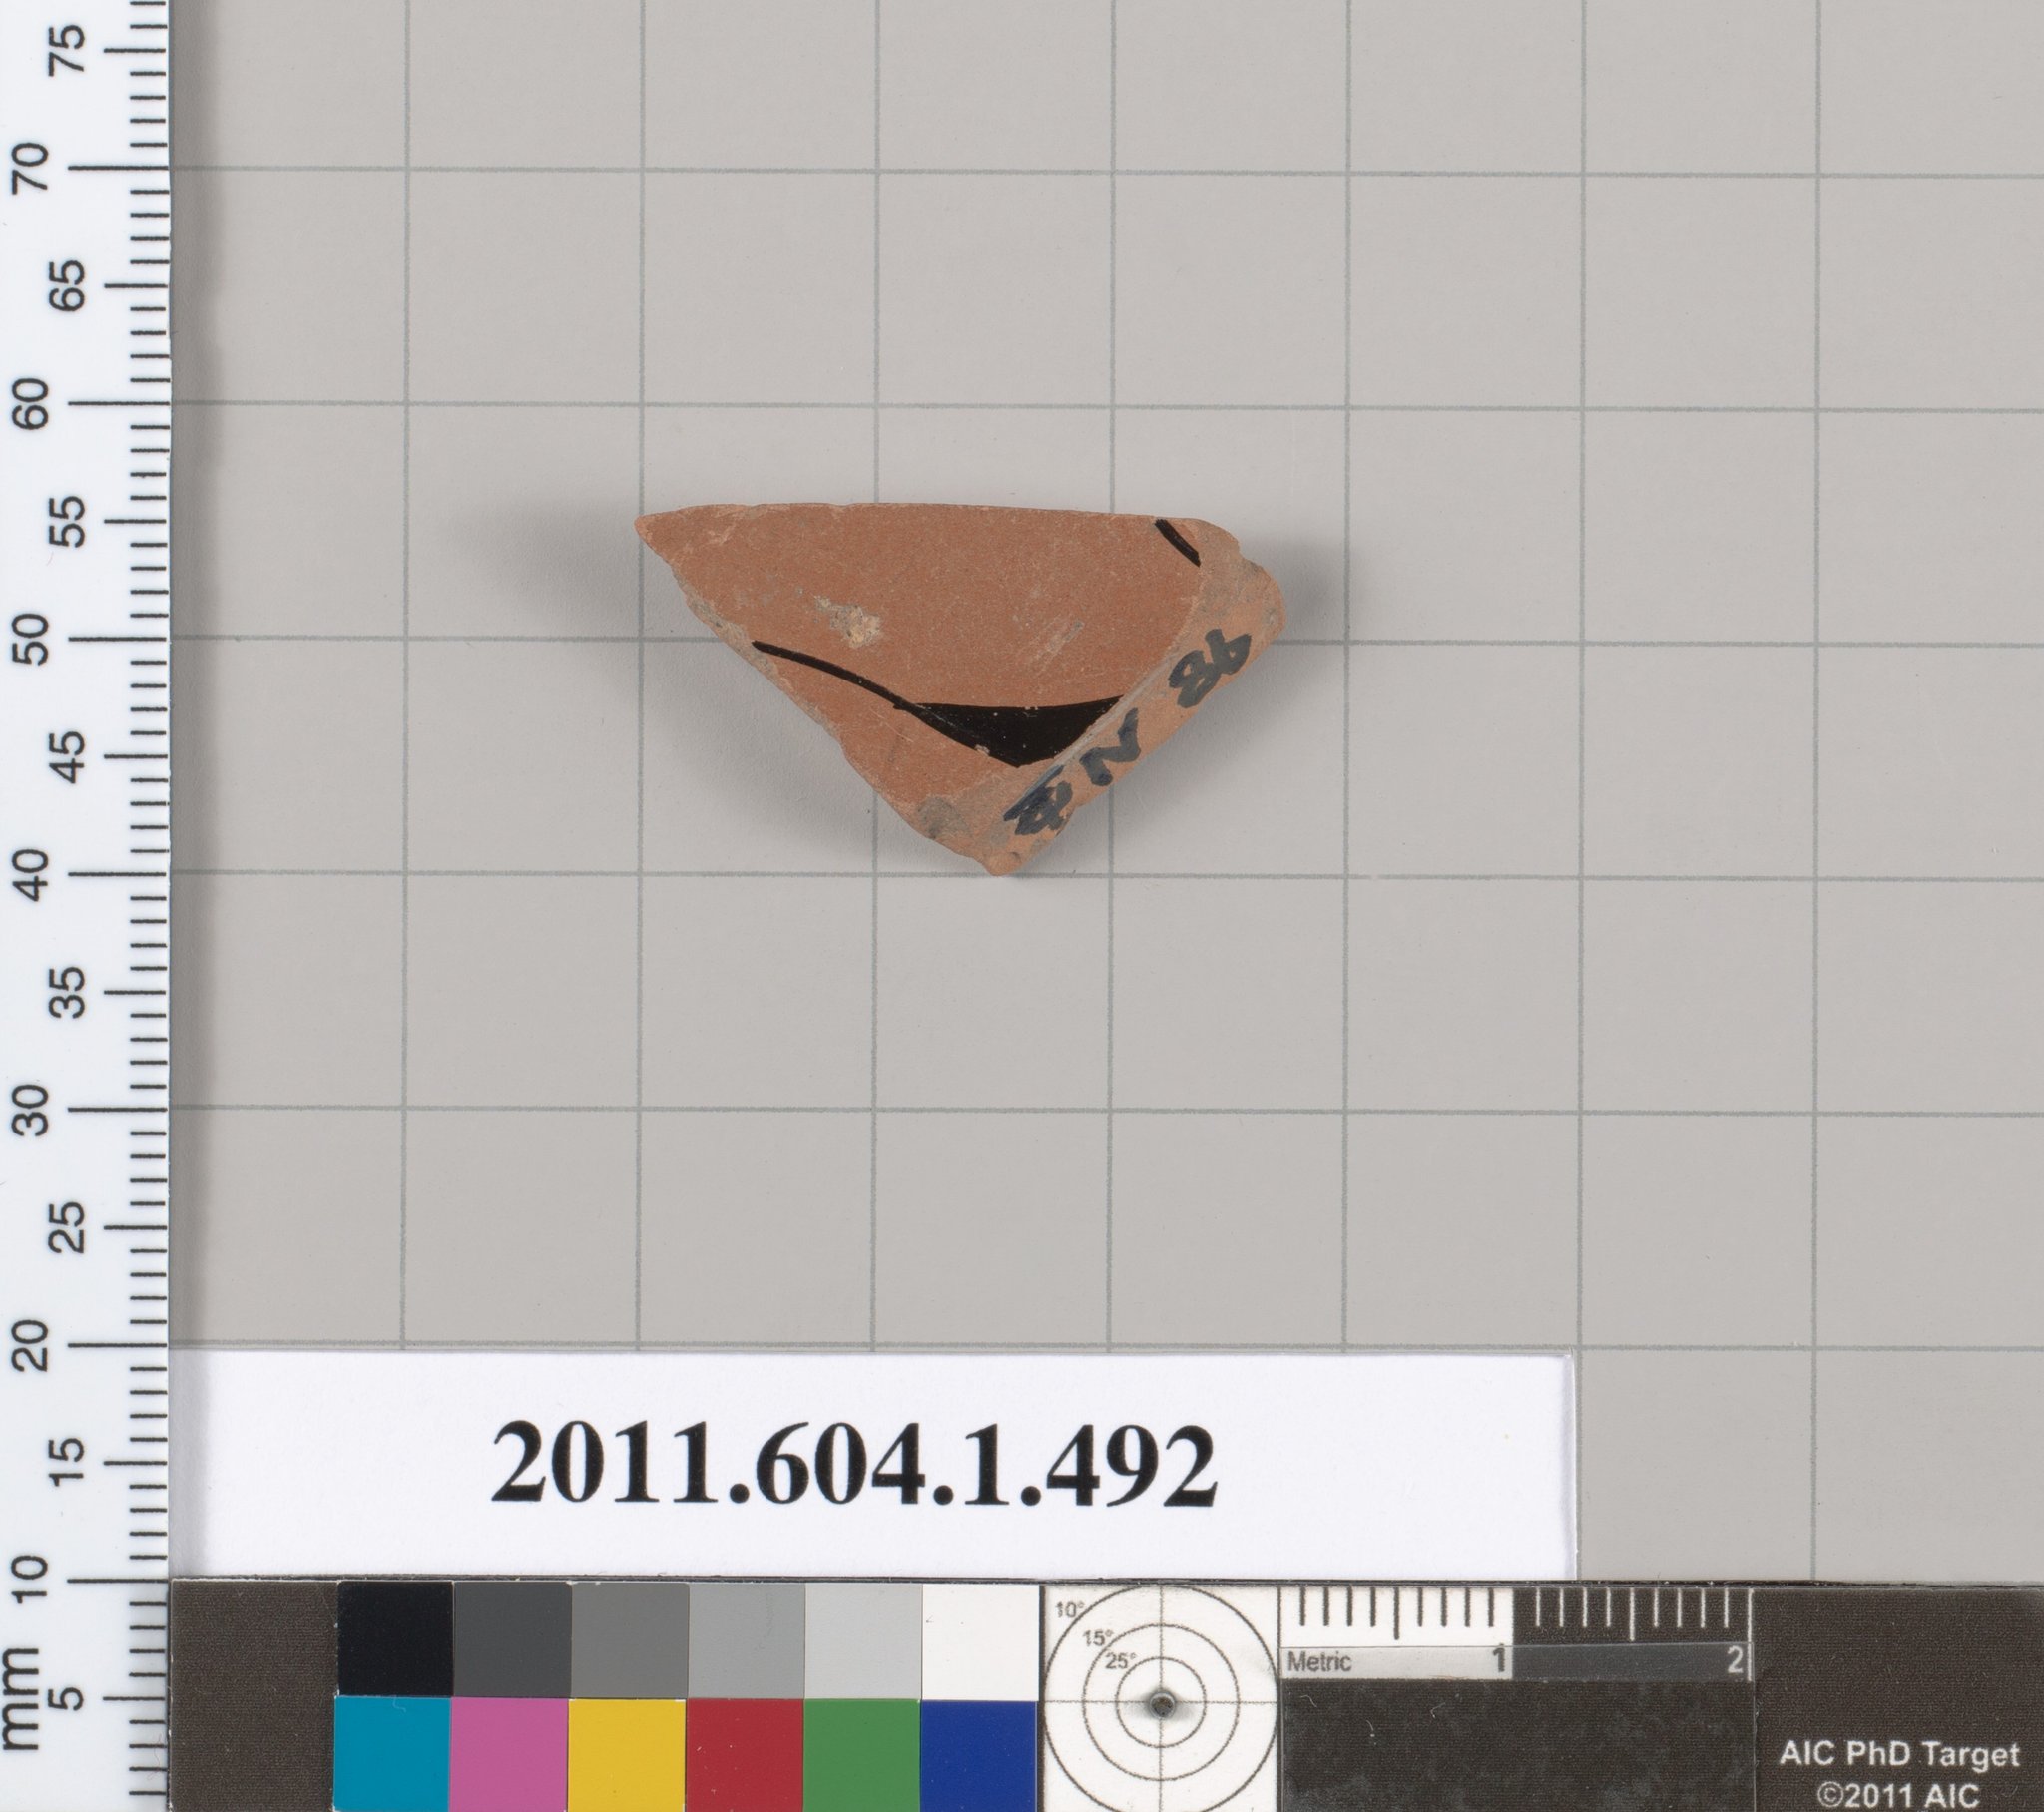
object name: kylix fragment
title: Terracotta fragment of a kylix (drinking cup)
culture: greek, attic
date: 490-480 BCE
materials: terracotta